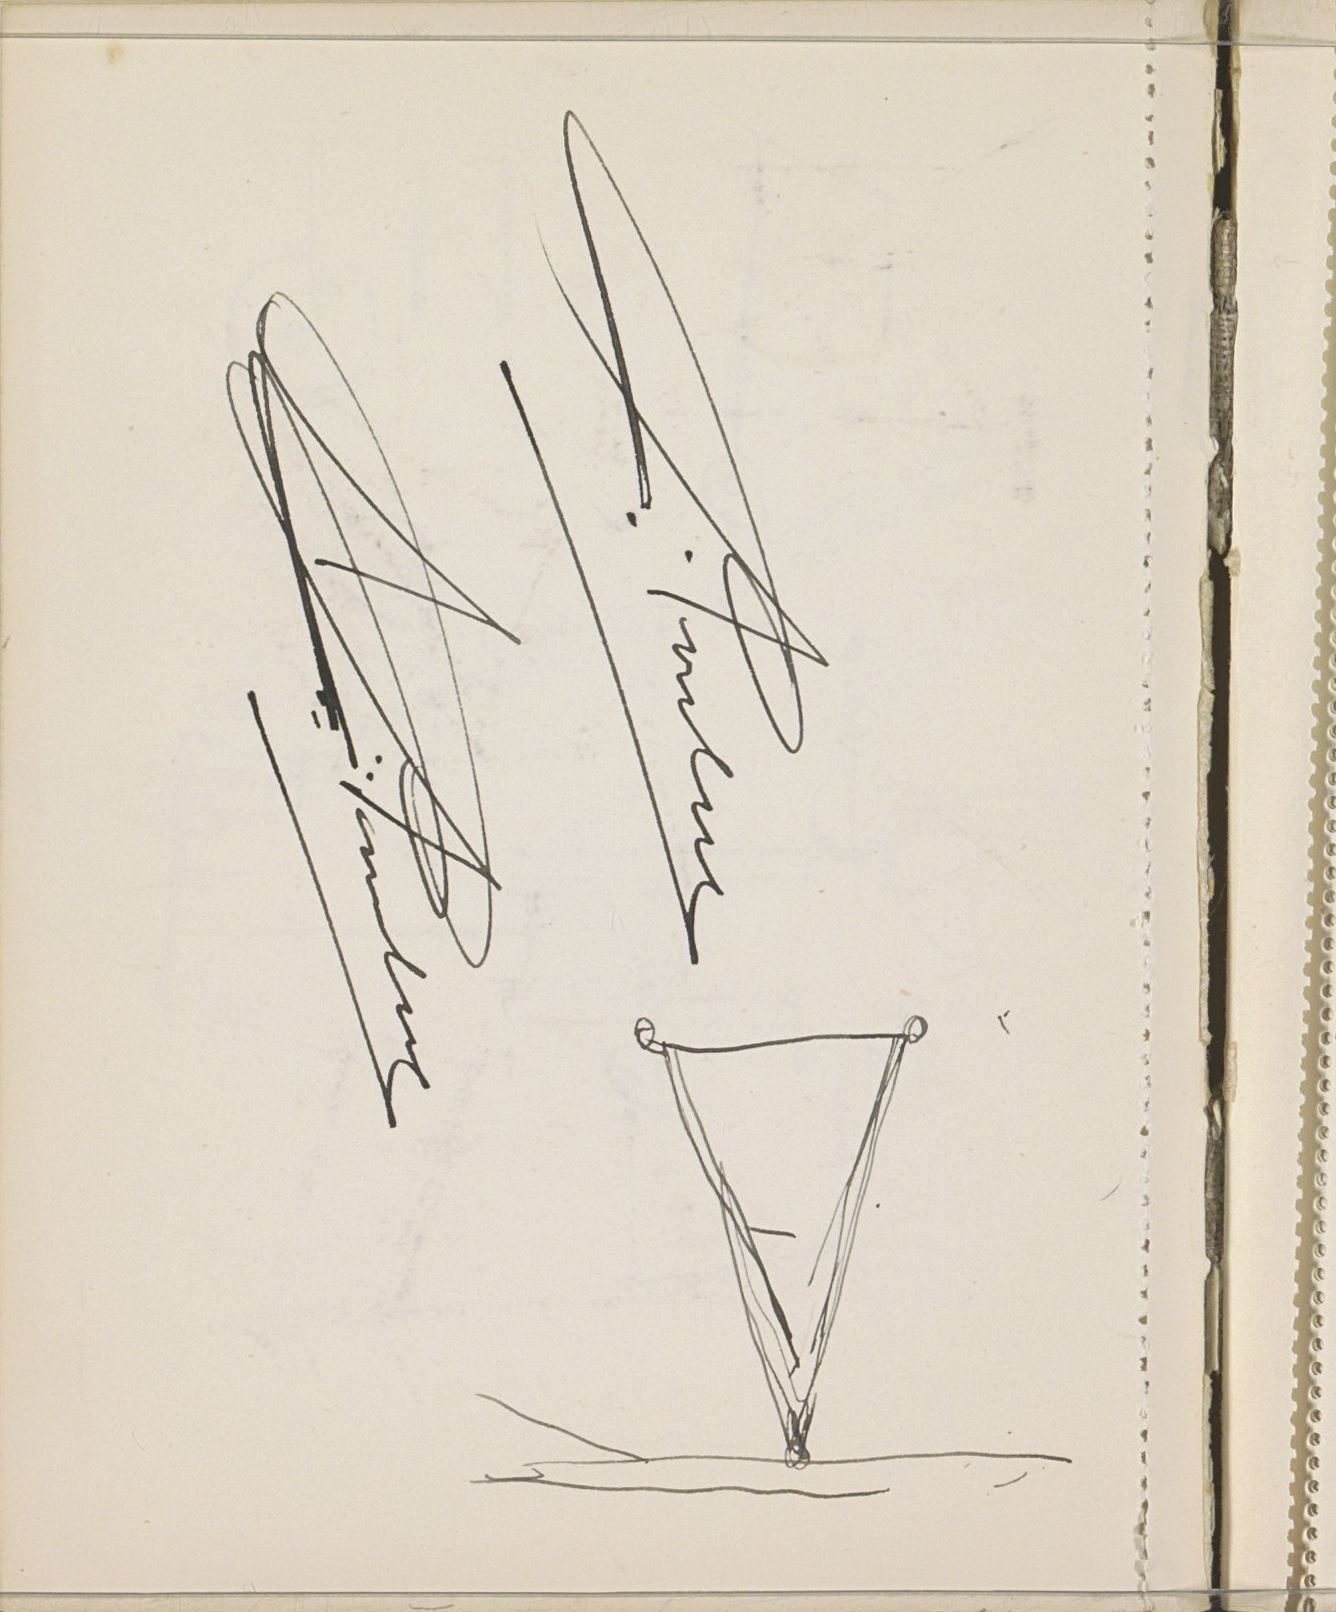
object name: sketchbook leaf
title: Driehoek, mogelijk een vlag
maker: reijer stolk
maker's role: draughtsman, print maker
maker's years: 1896-1945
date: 1906-1945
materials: ink, paper, pencil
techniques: pen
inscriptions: signature: ‘A. [...]a[...]ene’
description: Blad 19 verso uit een schetsboek met 42 bladen.